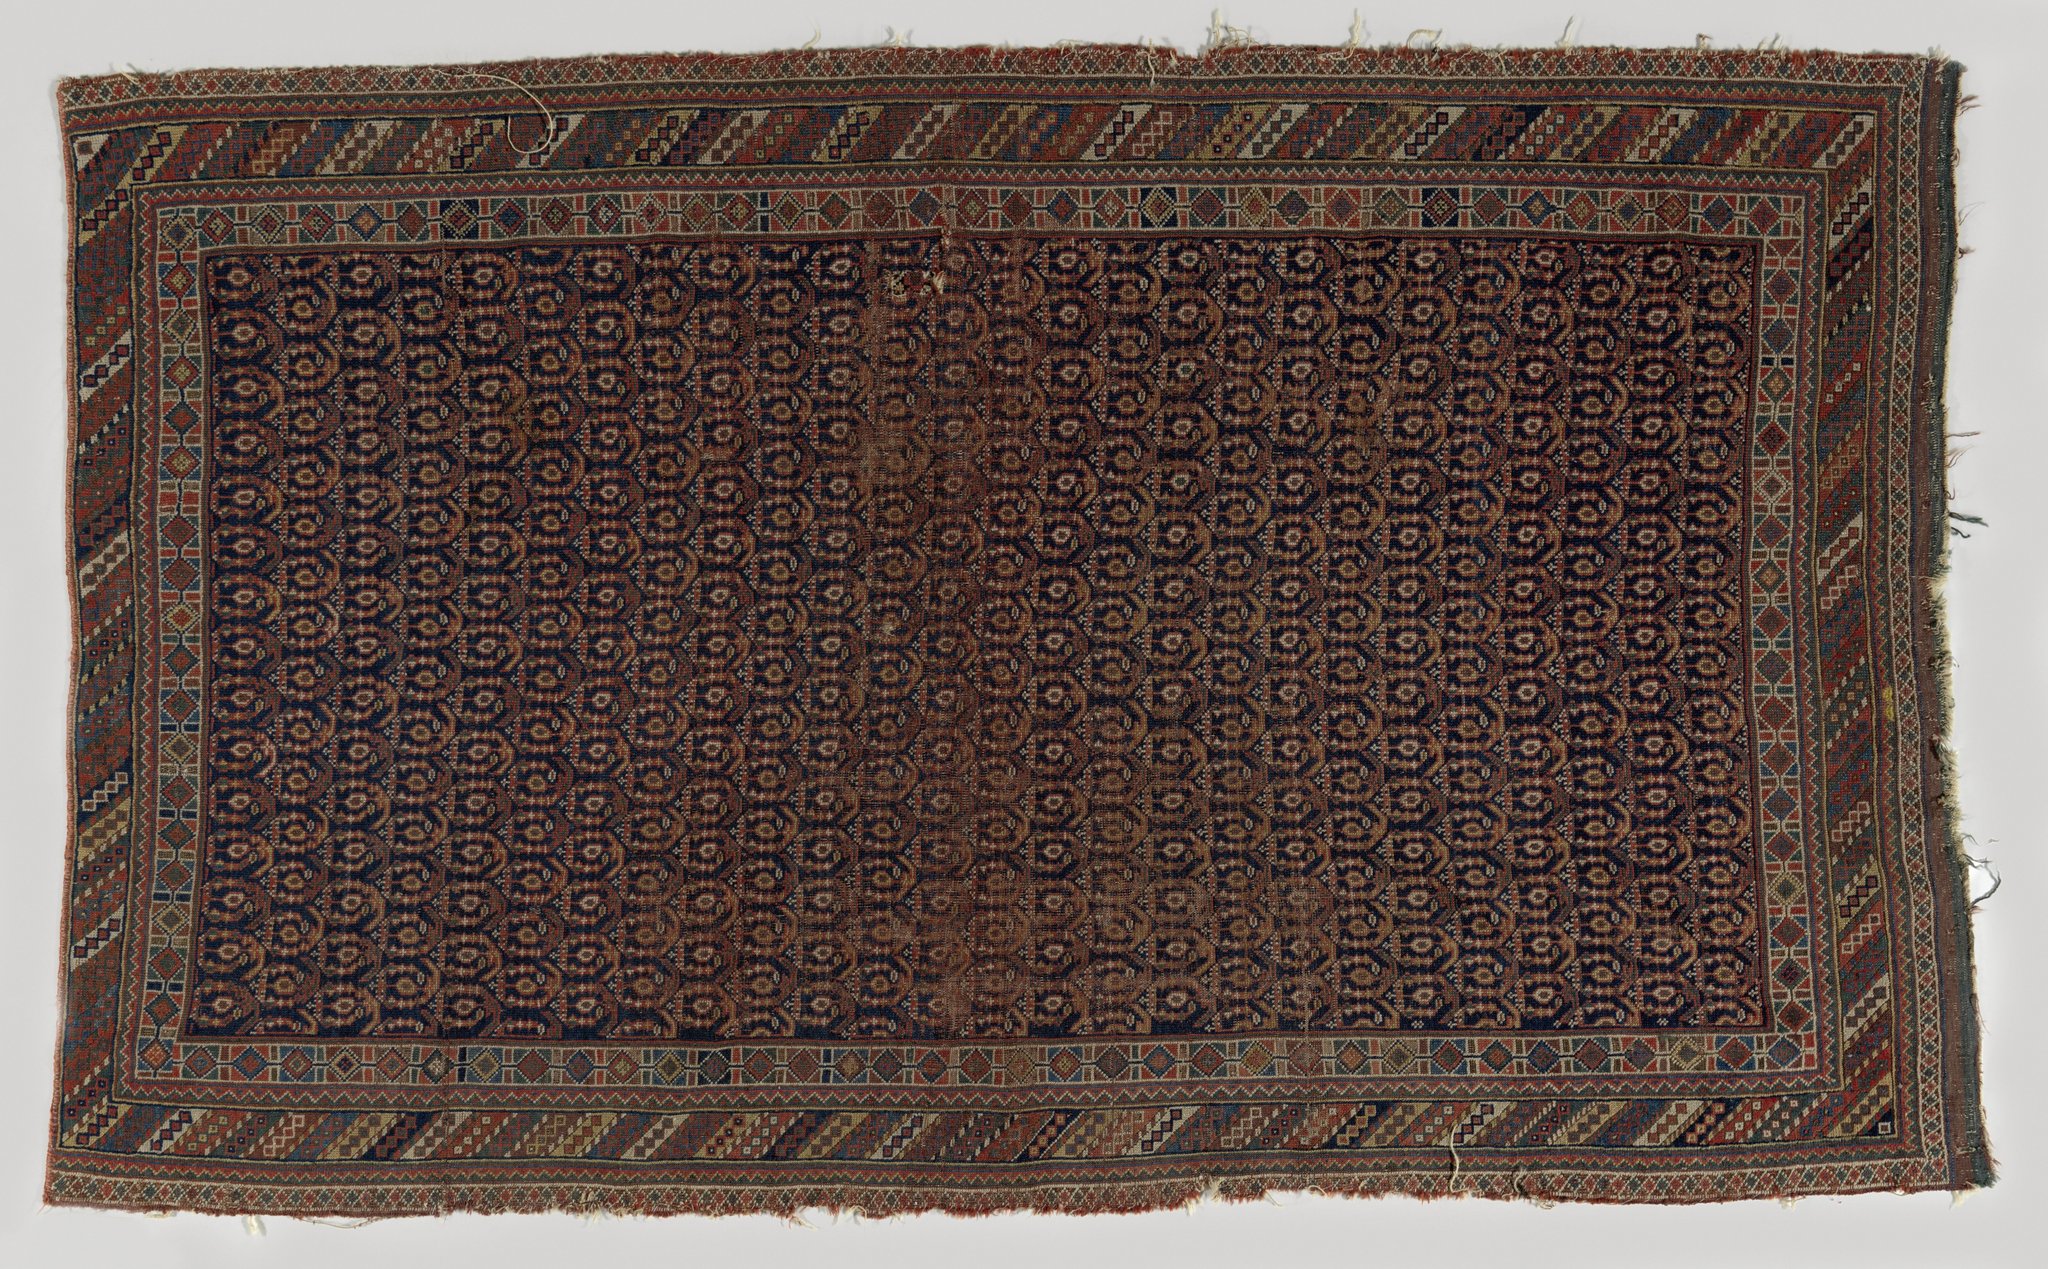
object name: oriental rug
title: Oosters tapijt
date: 1850-1900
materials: wool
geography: fars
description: Oosters tapijt van geknoopte wol waarvan het middenveld versierd is met rijen botehs. Vijf randen met een eenvoudig geometrisch patroon. Vermoedelijk geweven door Afshar nomaden.